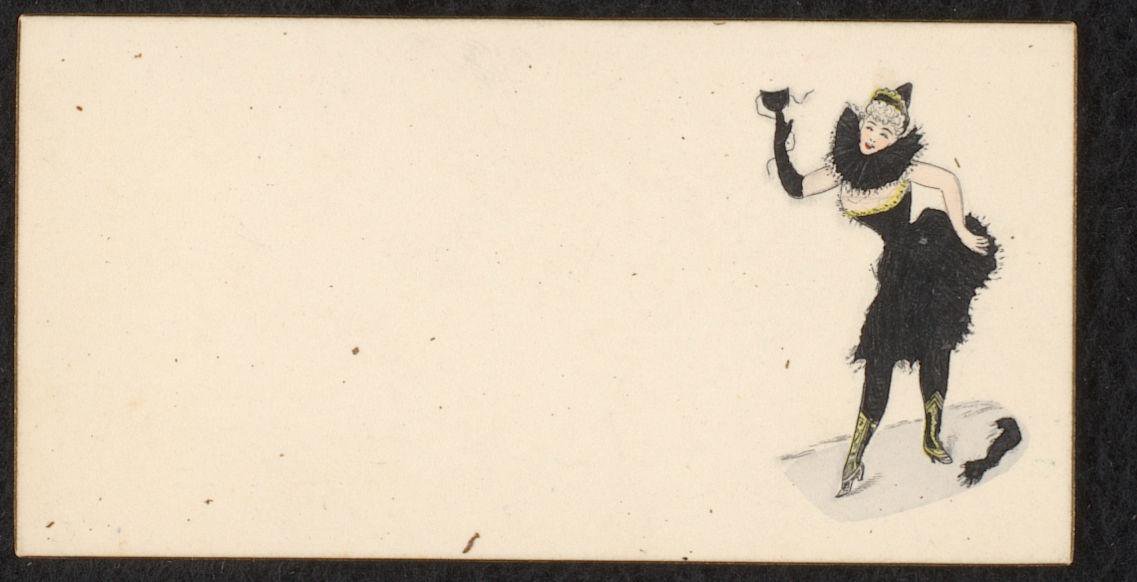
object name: photomechanical print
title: Vrouw in feestelijke kleding met masker en lange handschoenen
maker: Anonymous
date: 1870-1920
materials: paint, paper, watercolor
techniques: hand coloring, printing block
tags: mask, party clothes, festive attire, dress, gown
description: Mogelijk een (oningevulde) plaatskaart voor een diner. Bij gebrek aan gegevens over de vervaardiger is voor de bepaling van de rechten van dit object gebruik gemaakt van de vervaardigingsdatum.